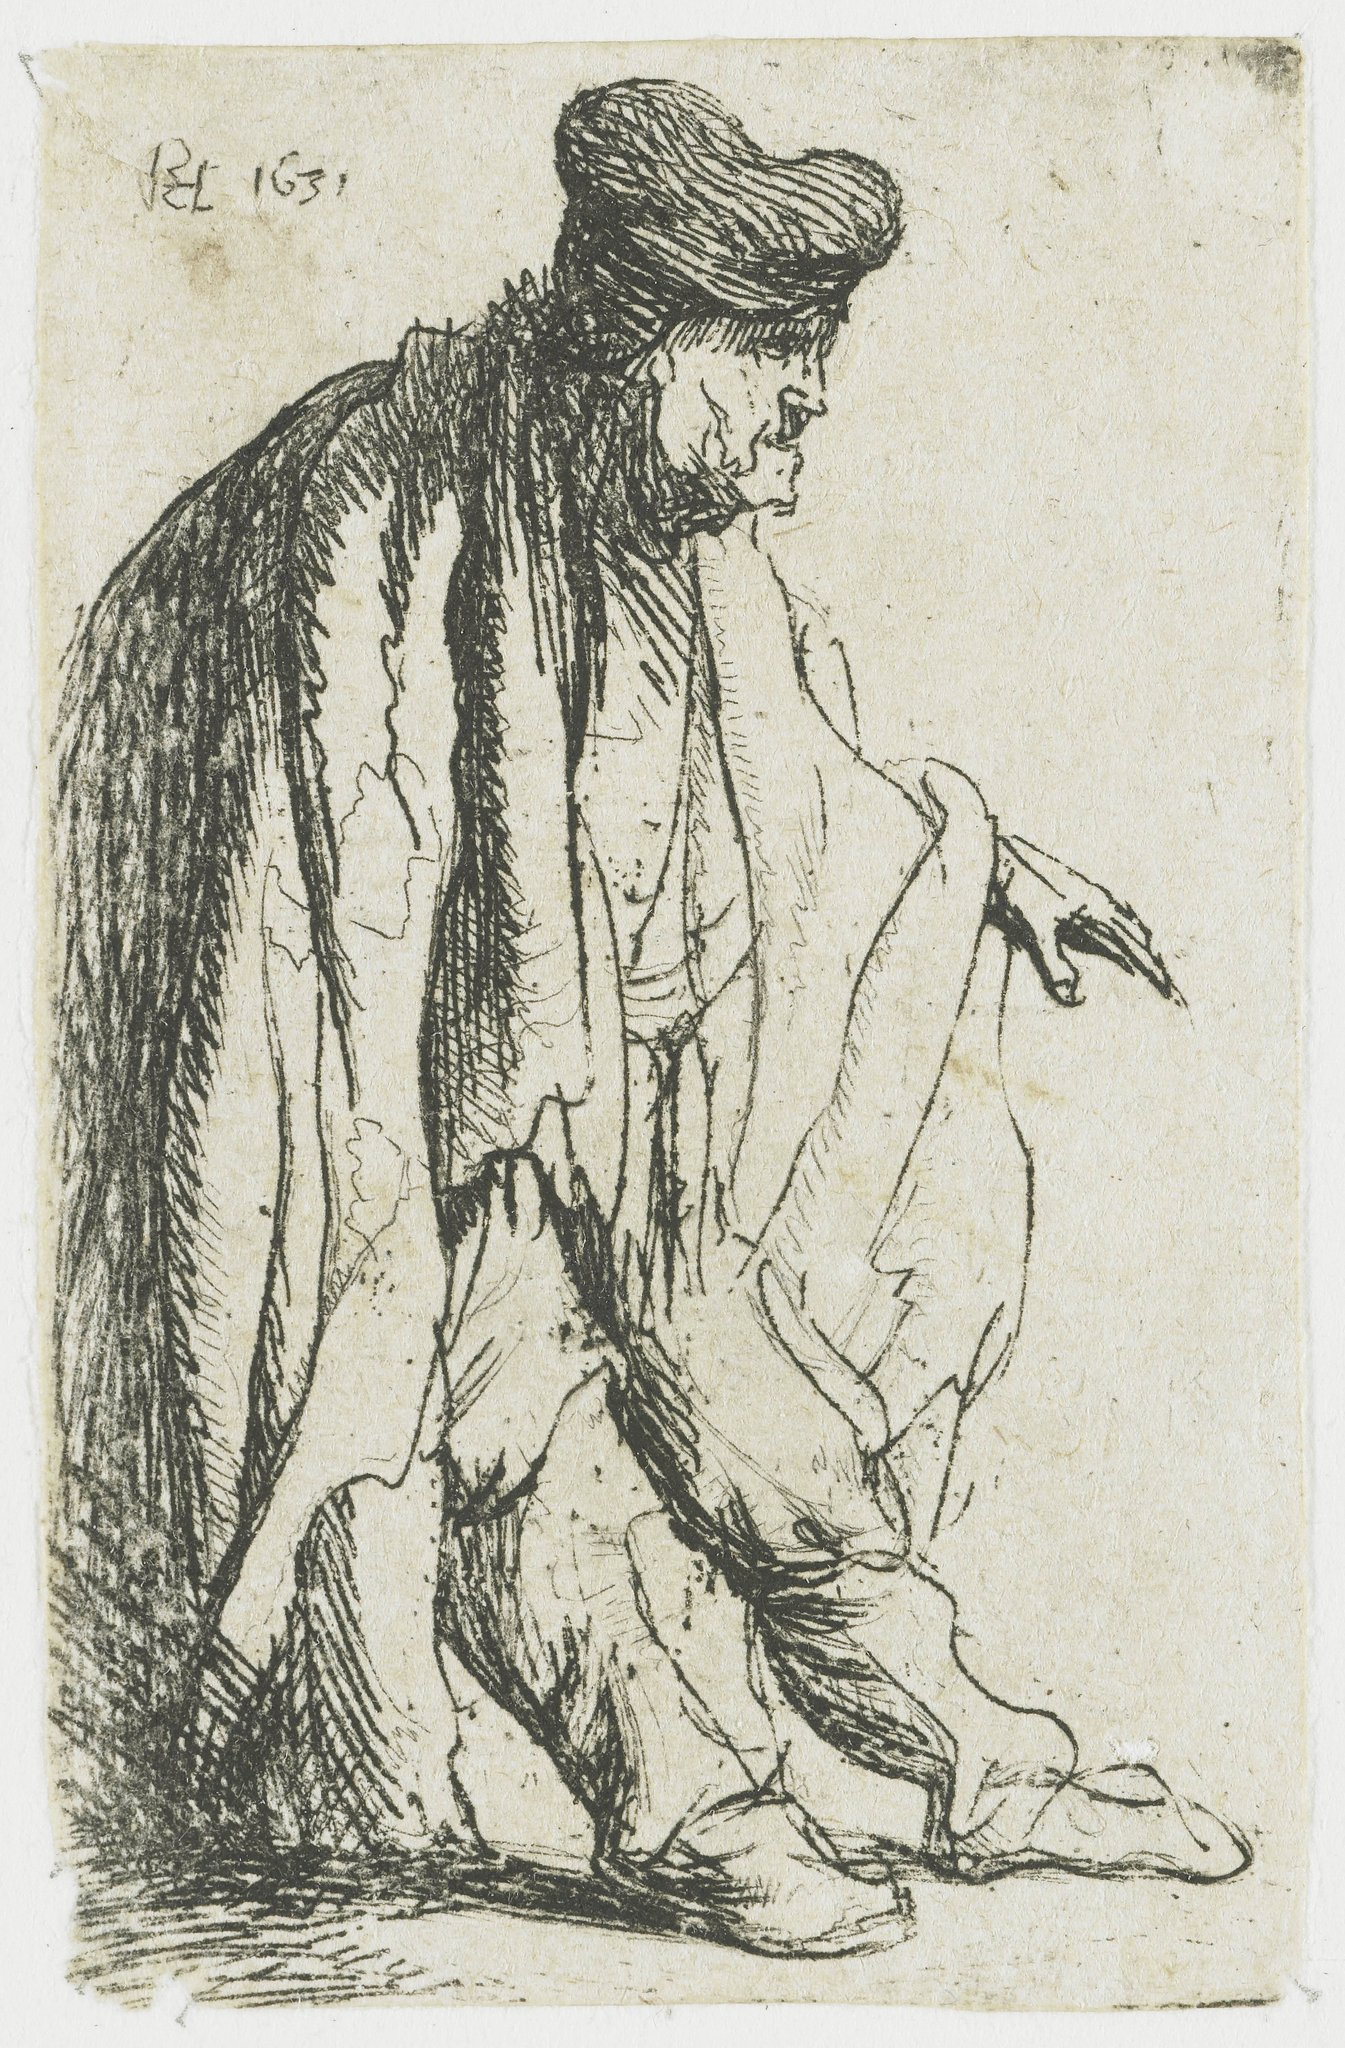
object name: print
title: Beggar with his left hand extended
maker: rembrandt van rijn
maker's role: draughtsman, painter, print maker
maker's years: 1606-1669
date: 1629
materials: paper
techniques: etching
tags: beggar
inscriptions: monogram and date: ‘RHL 1631’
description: Gedateerd 1631, maar waarschijnlijk niet door Rembrandt.